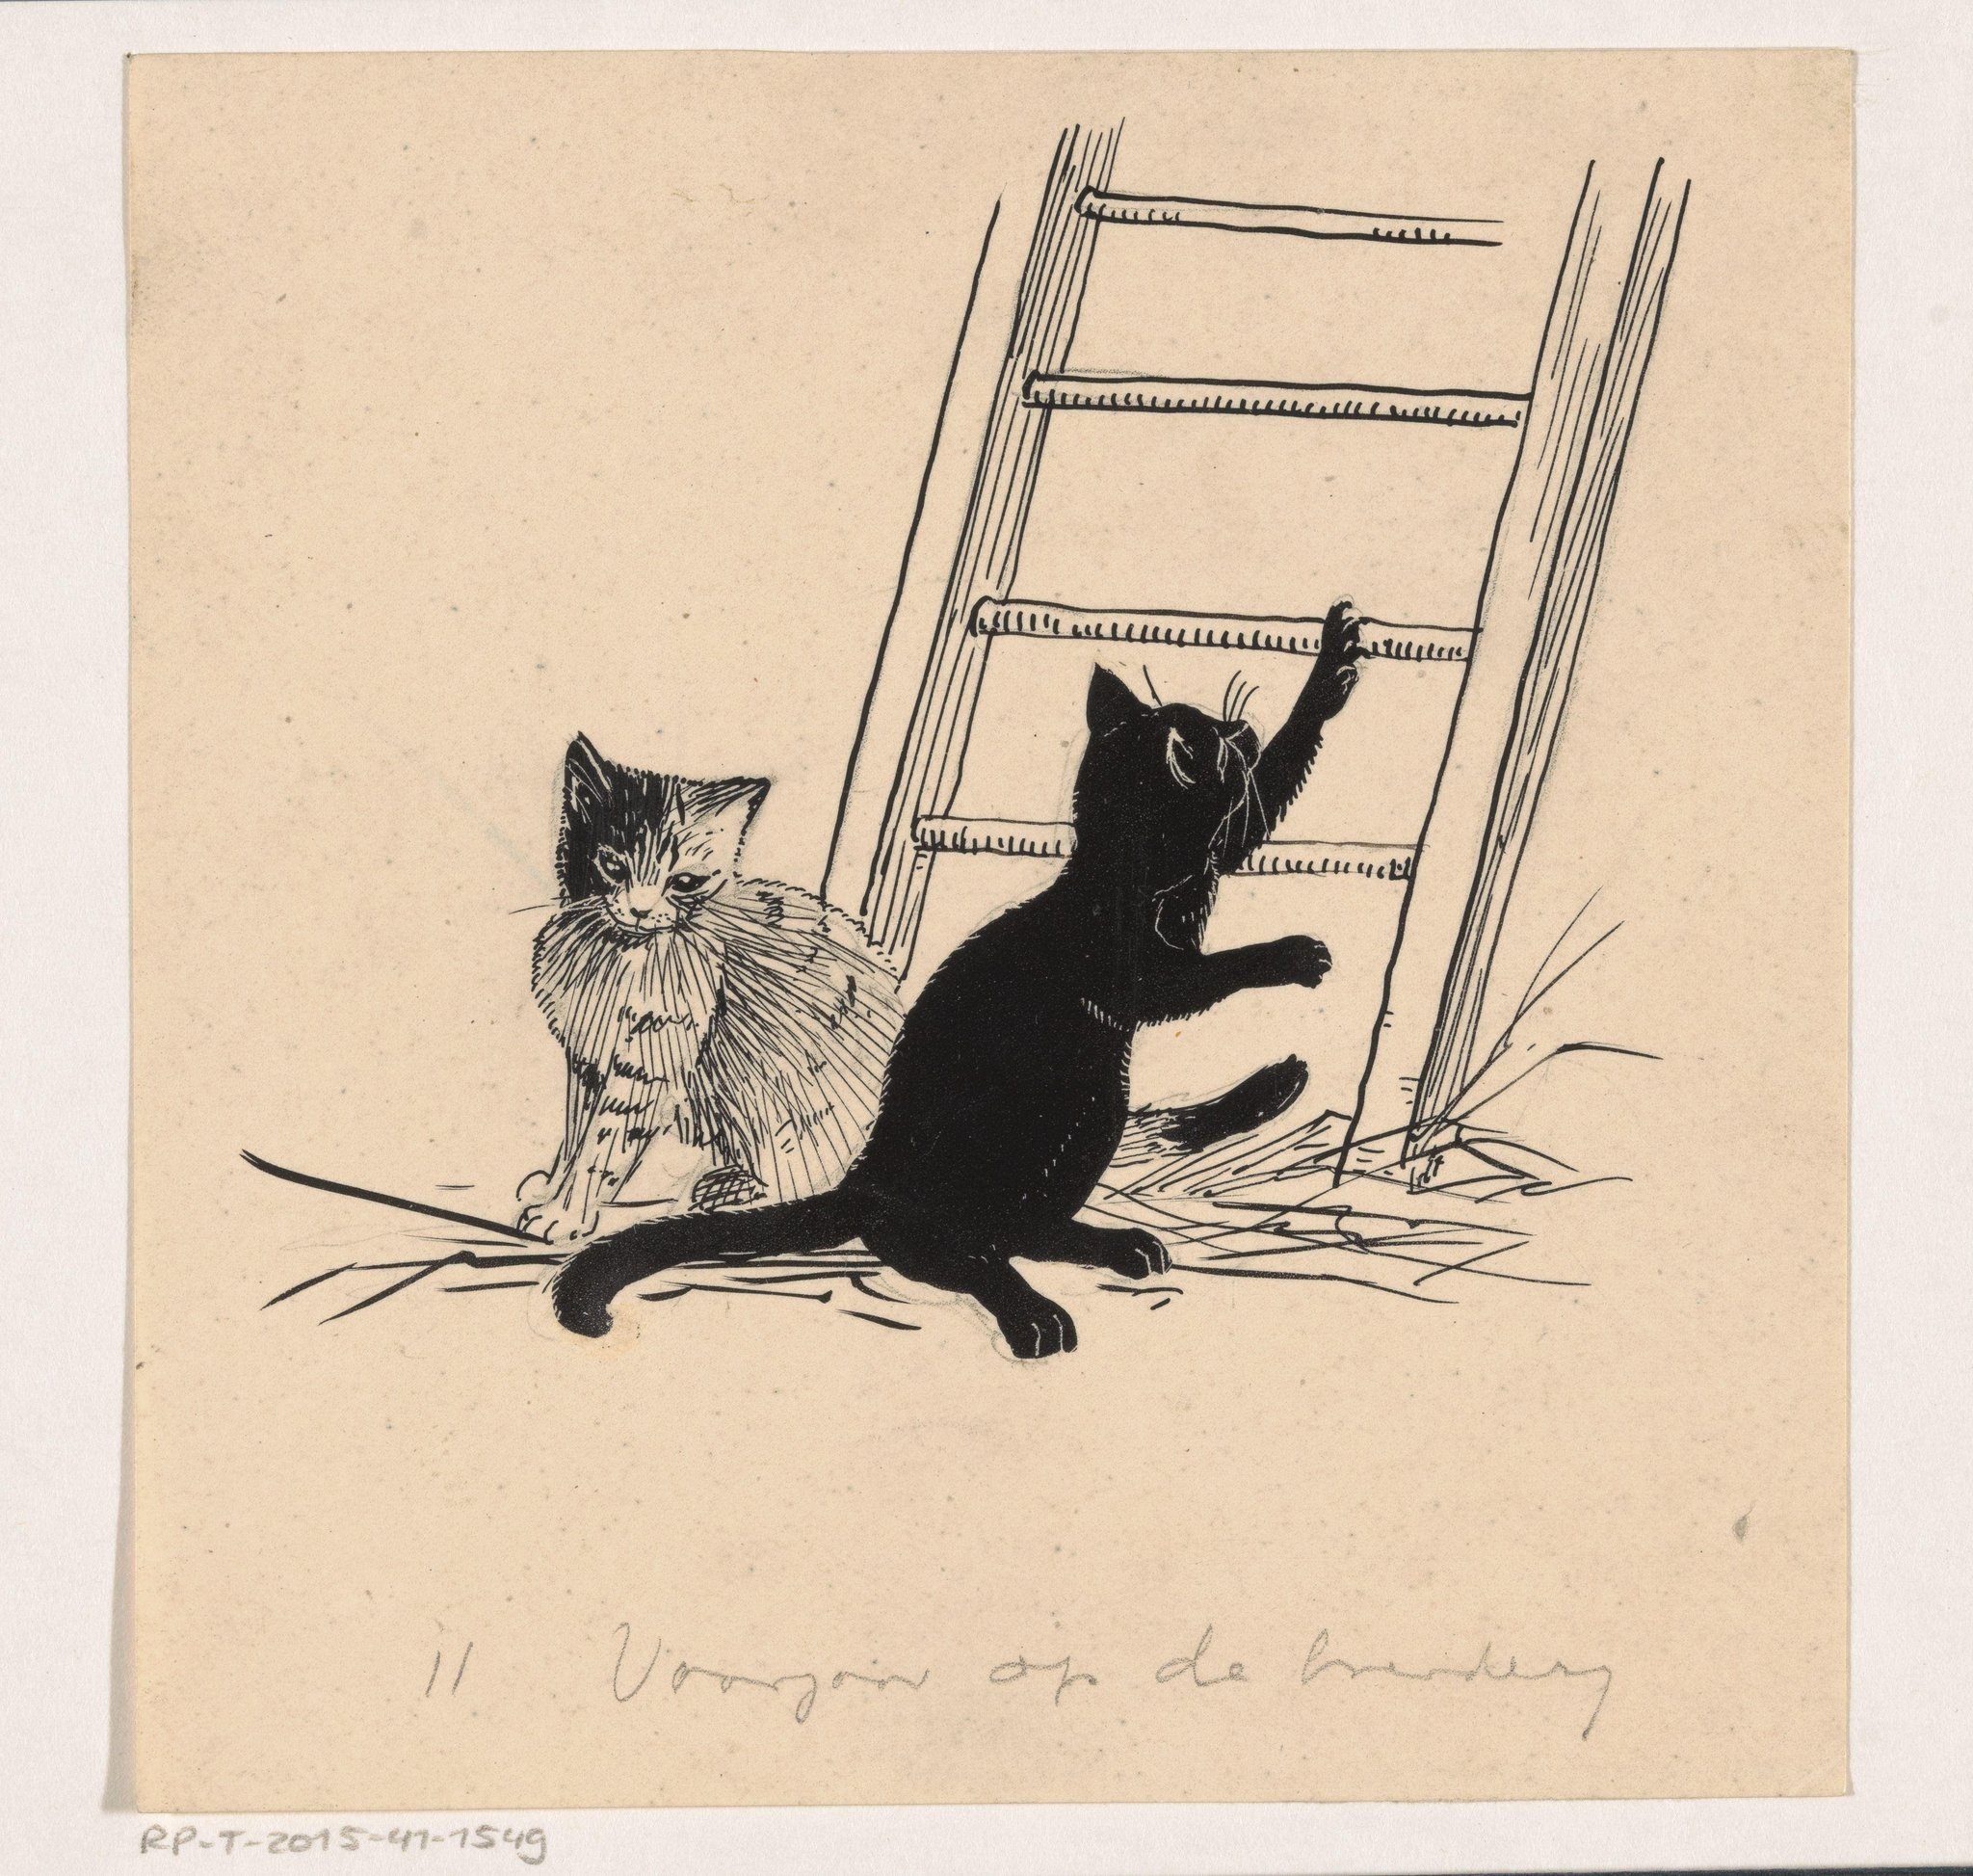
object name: boekillustratie ontwerp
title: Twee katten in het stro bij een ladder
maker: henri verstijnen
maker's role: draughtsman, print maker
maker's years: 1882-1940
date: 1892-1940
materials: ink, paper, pencil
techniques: brush, pen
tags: cat, ladder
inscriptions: :, collector's mark: Lugt 2228, annotation: ‘11 Voorjaar op de boerderij’